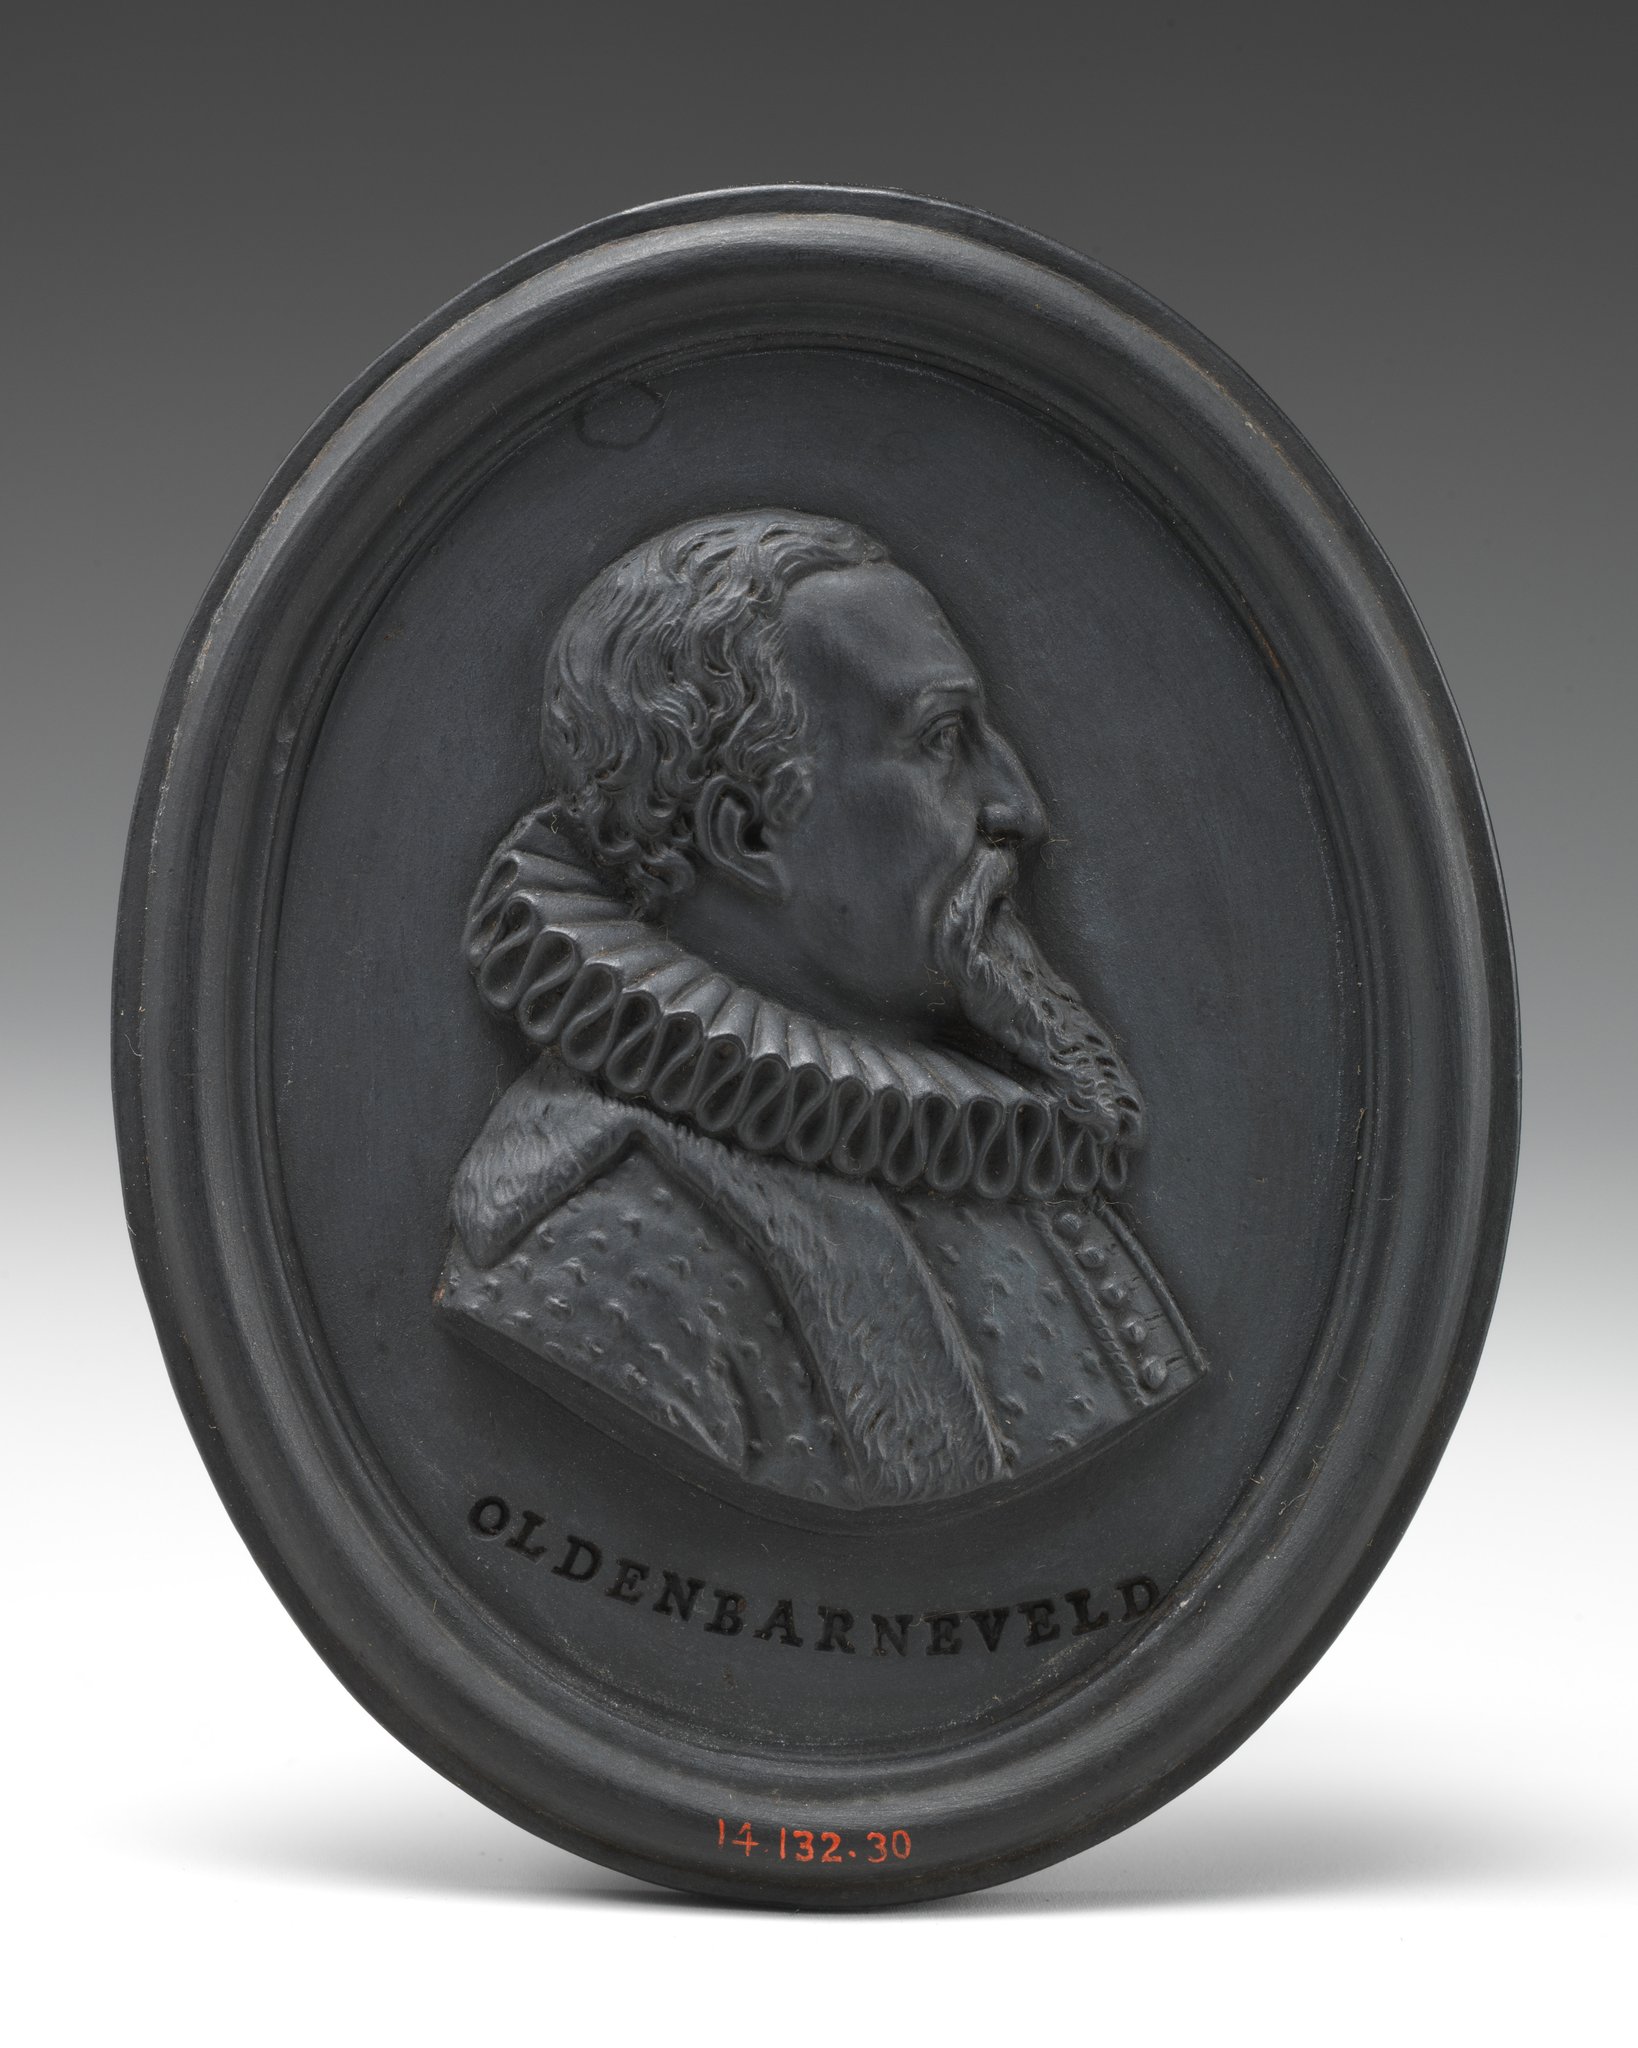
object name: medallion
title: Jan van Olden Barneveldt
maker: wedgwood and bentley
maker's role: maker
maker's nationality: british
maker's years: 1769-1780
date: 1701-1800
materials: stone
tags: men,profiles